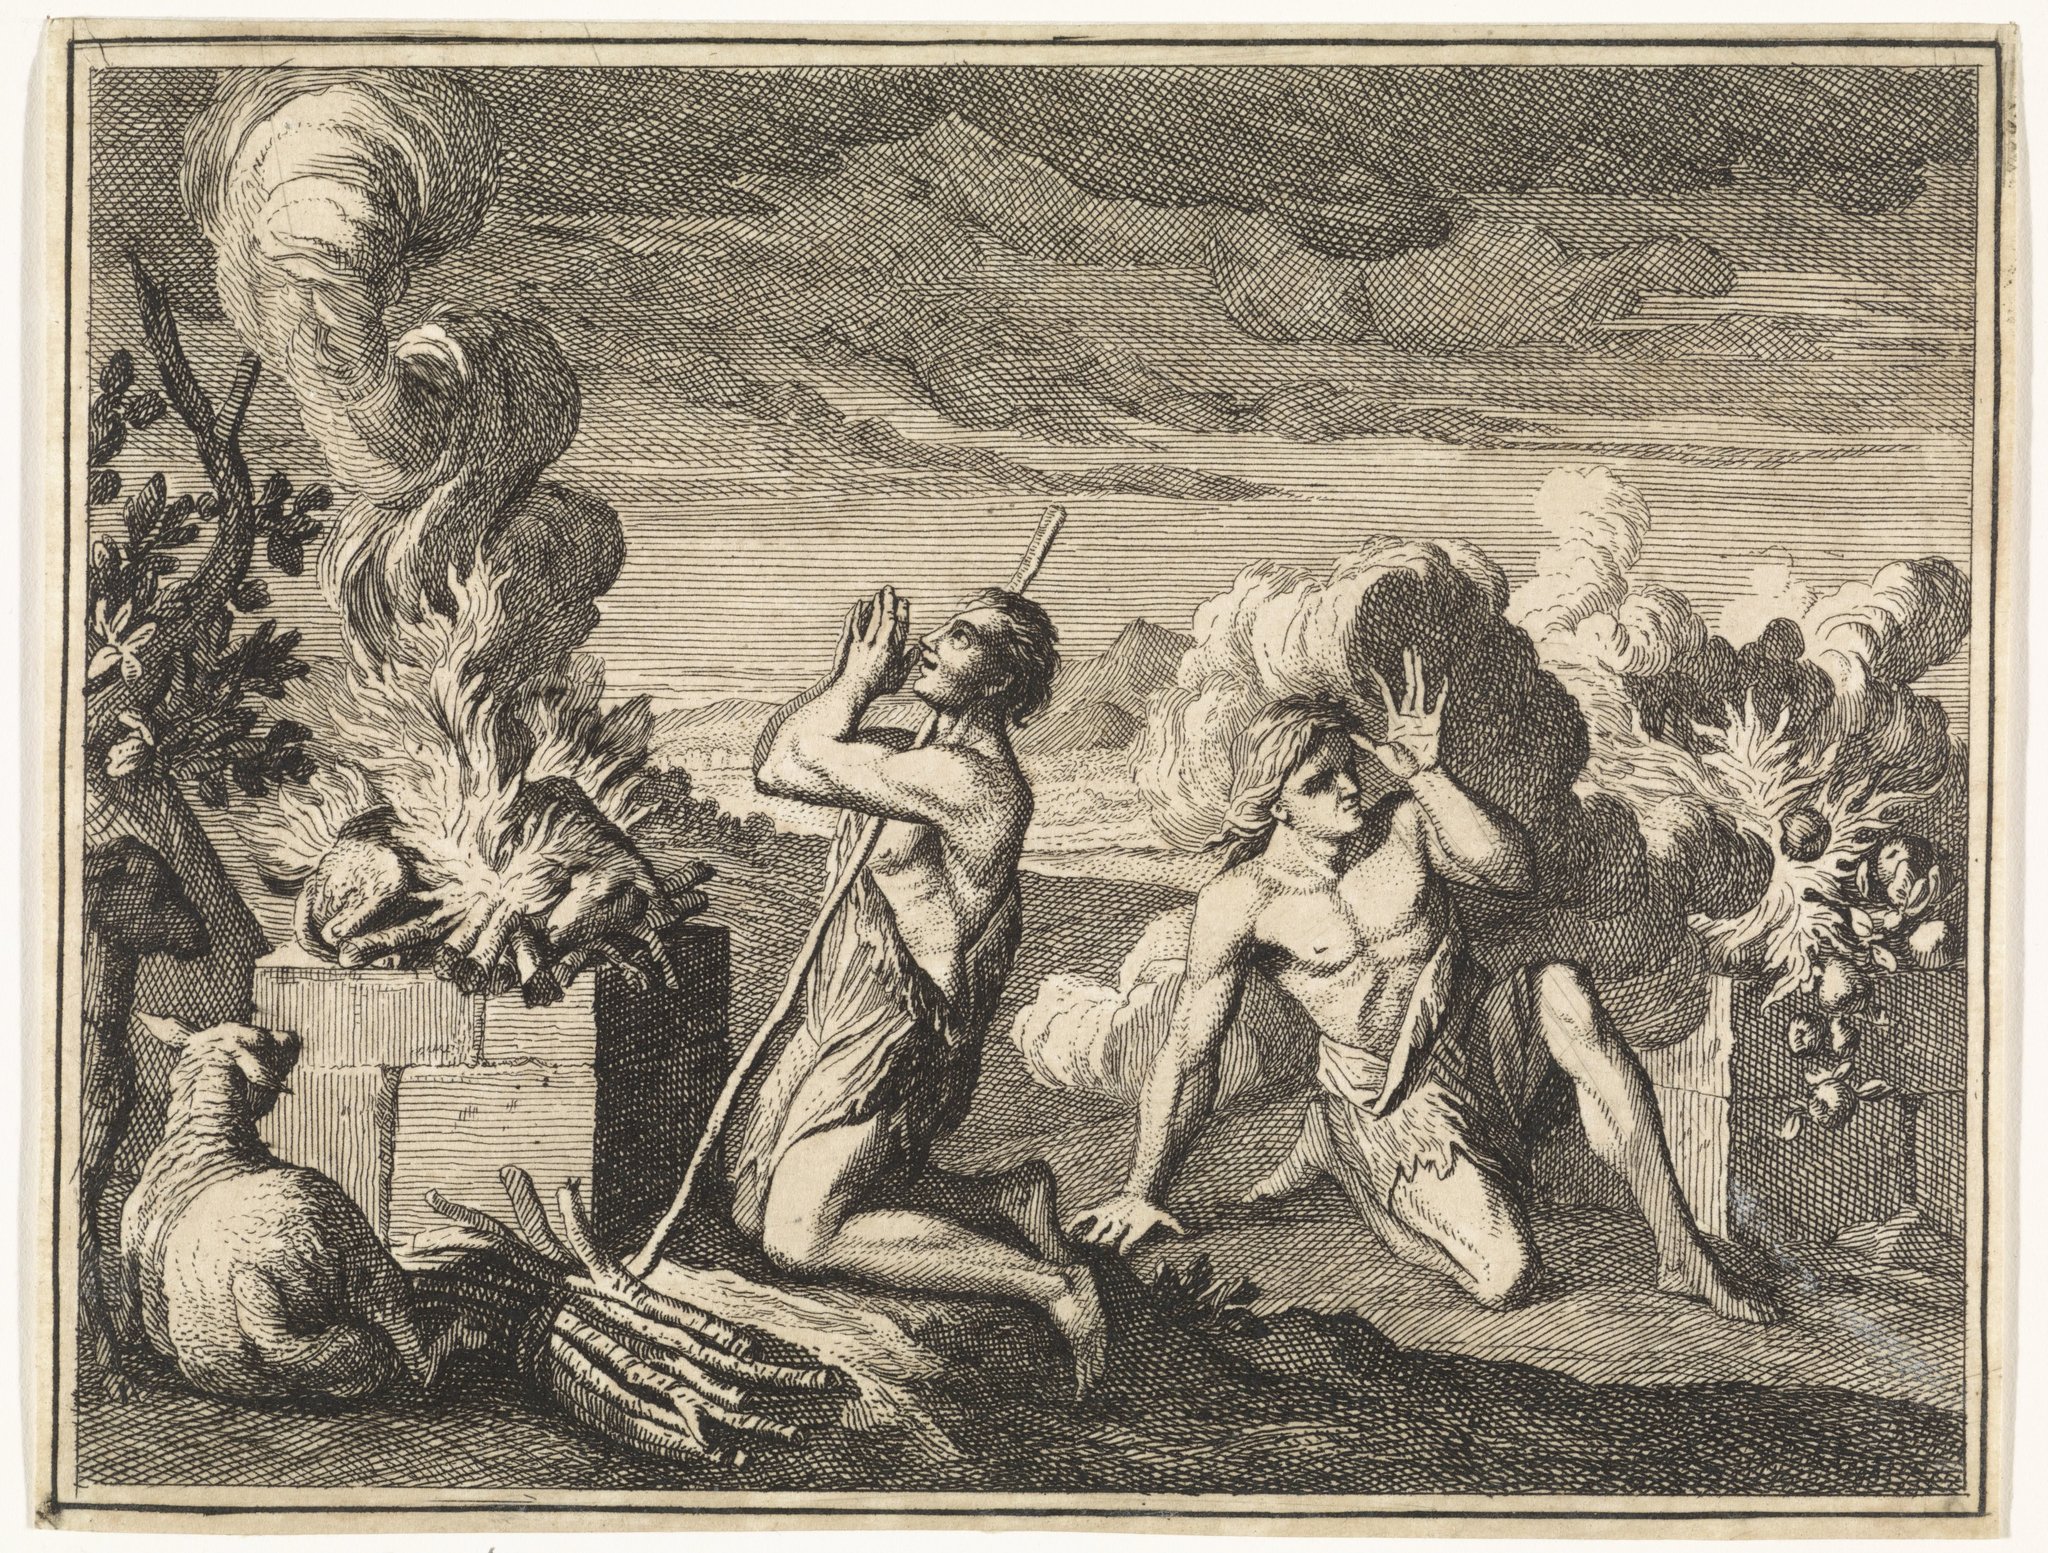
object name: print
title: Offer van Kaïn en Abel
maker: caspar luyken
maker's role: draughtsman, print maker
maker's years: 1672-1708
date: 1712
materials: paper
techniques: etching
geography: amsterdam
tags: the fume of abel's sacrifice goes straight to heaven, whereas the smoke of cain's offering is beaten down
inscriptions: number: ‘8’, collector's mark: Lugt 2228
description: Illustratie uit: Luyken, Jan. De schriftuurlyke geschiedenissen en gelykenissen van het Oude en Nieuwe Verbond, 2 delen. Amsterdam: Wed. Pieter Arentsz II en Cornelis van der Sys, 1712, dl. I.